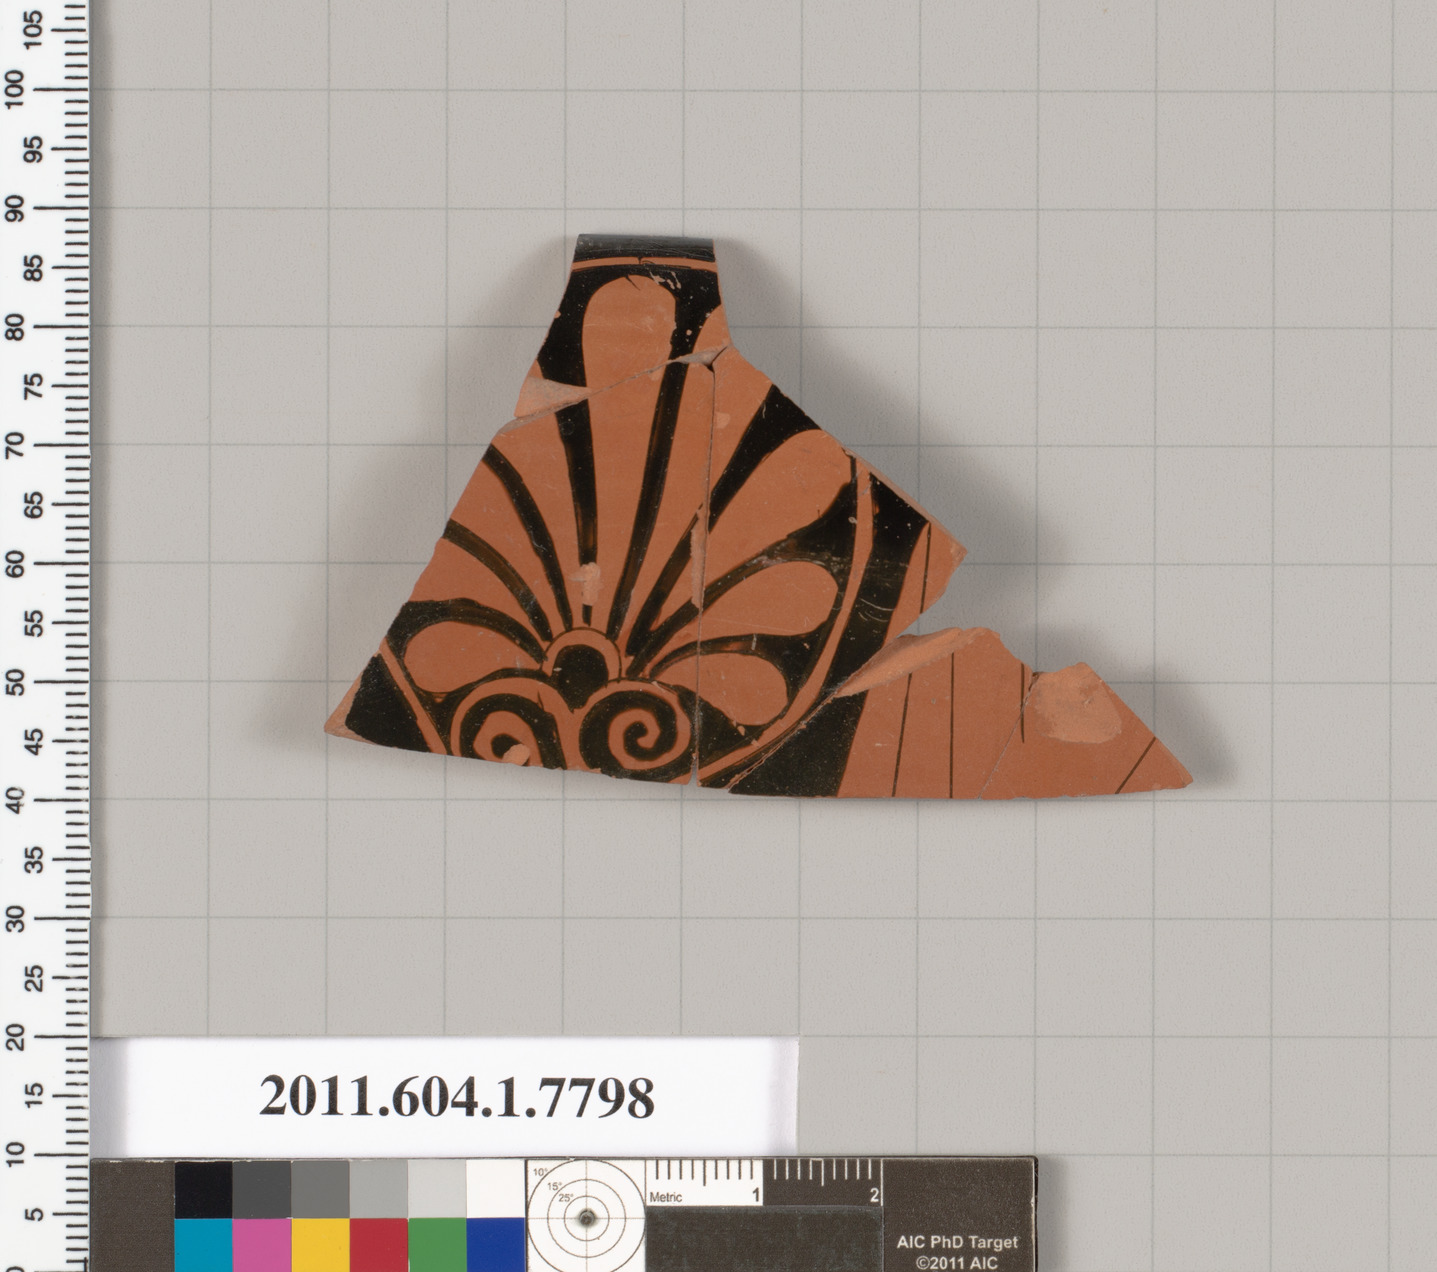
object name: kylix fragment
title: Terracotta fragment of a kylix (drinking cup)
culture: greek, attic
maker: bordeaux painter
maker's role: artist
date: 470-460 BCE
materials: terracotta